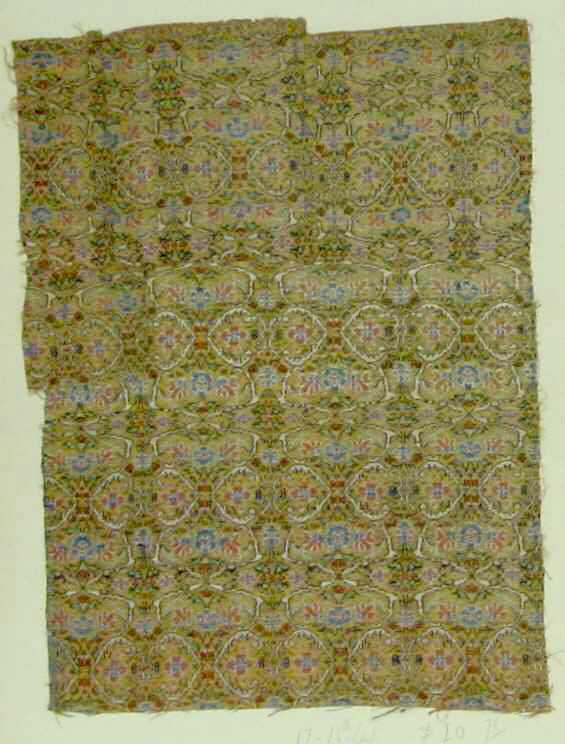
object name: textile fragment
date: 1601-1800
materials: metal thread, silk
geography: iran